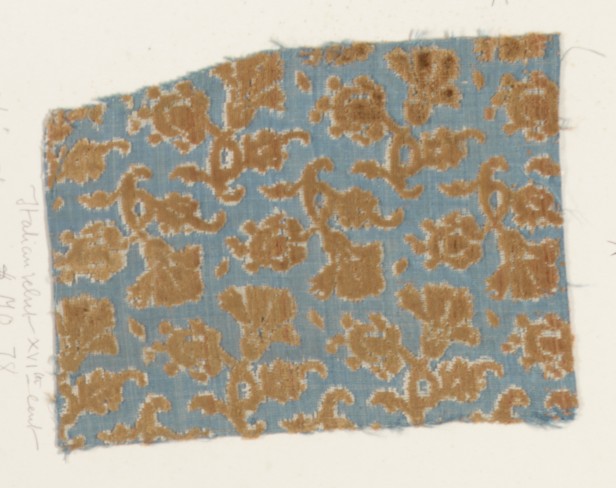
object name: fragment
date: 1501-1600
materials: silk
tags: flowers